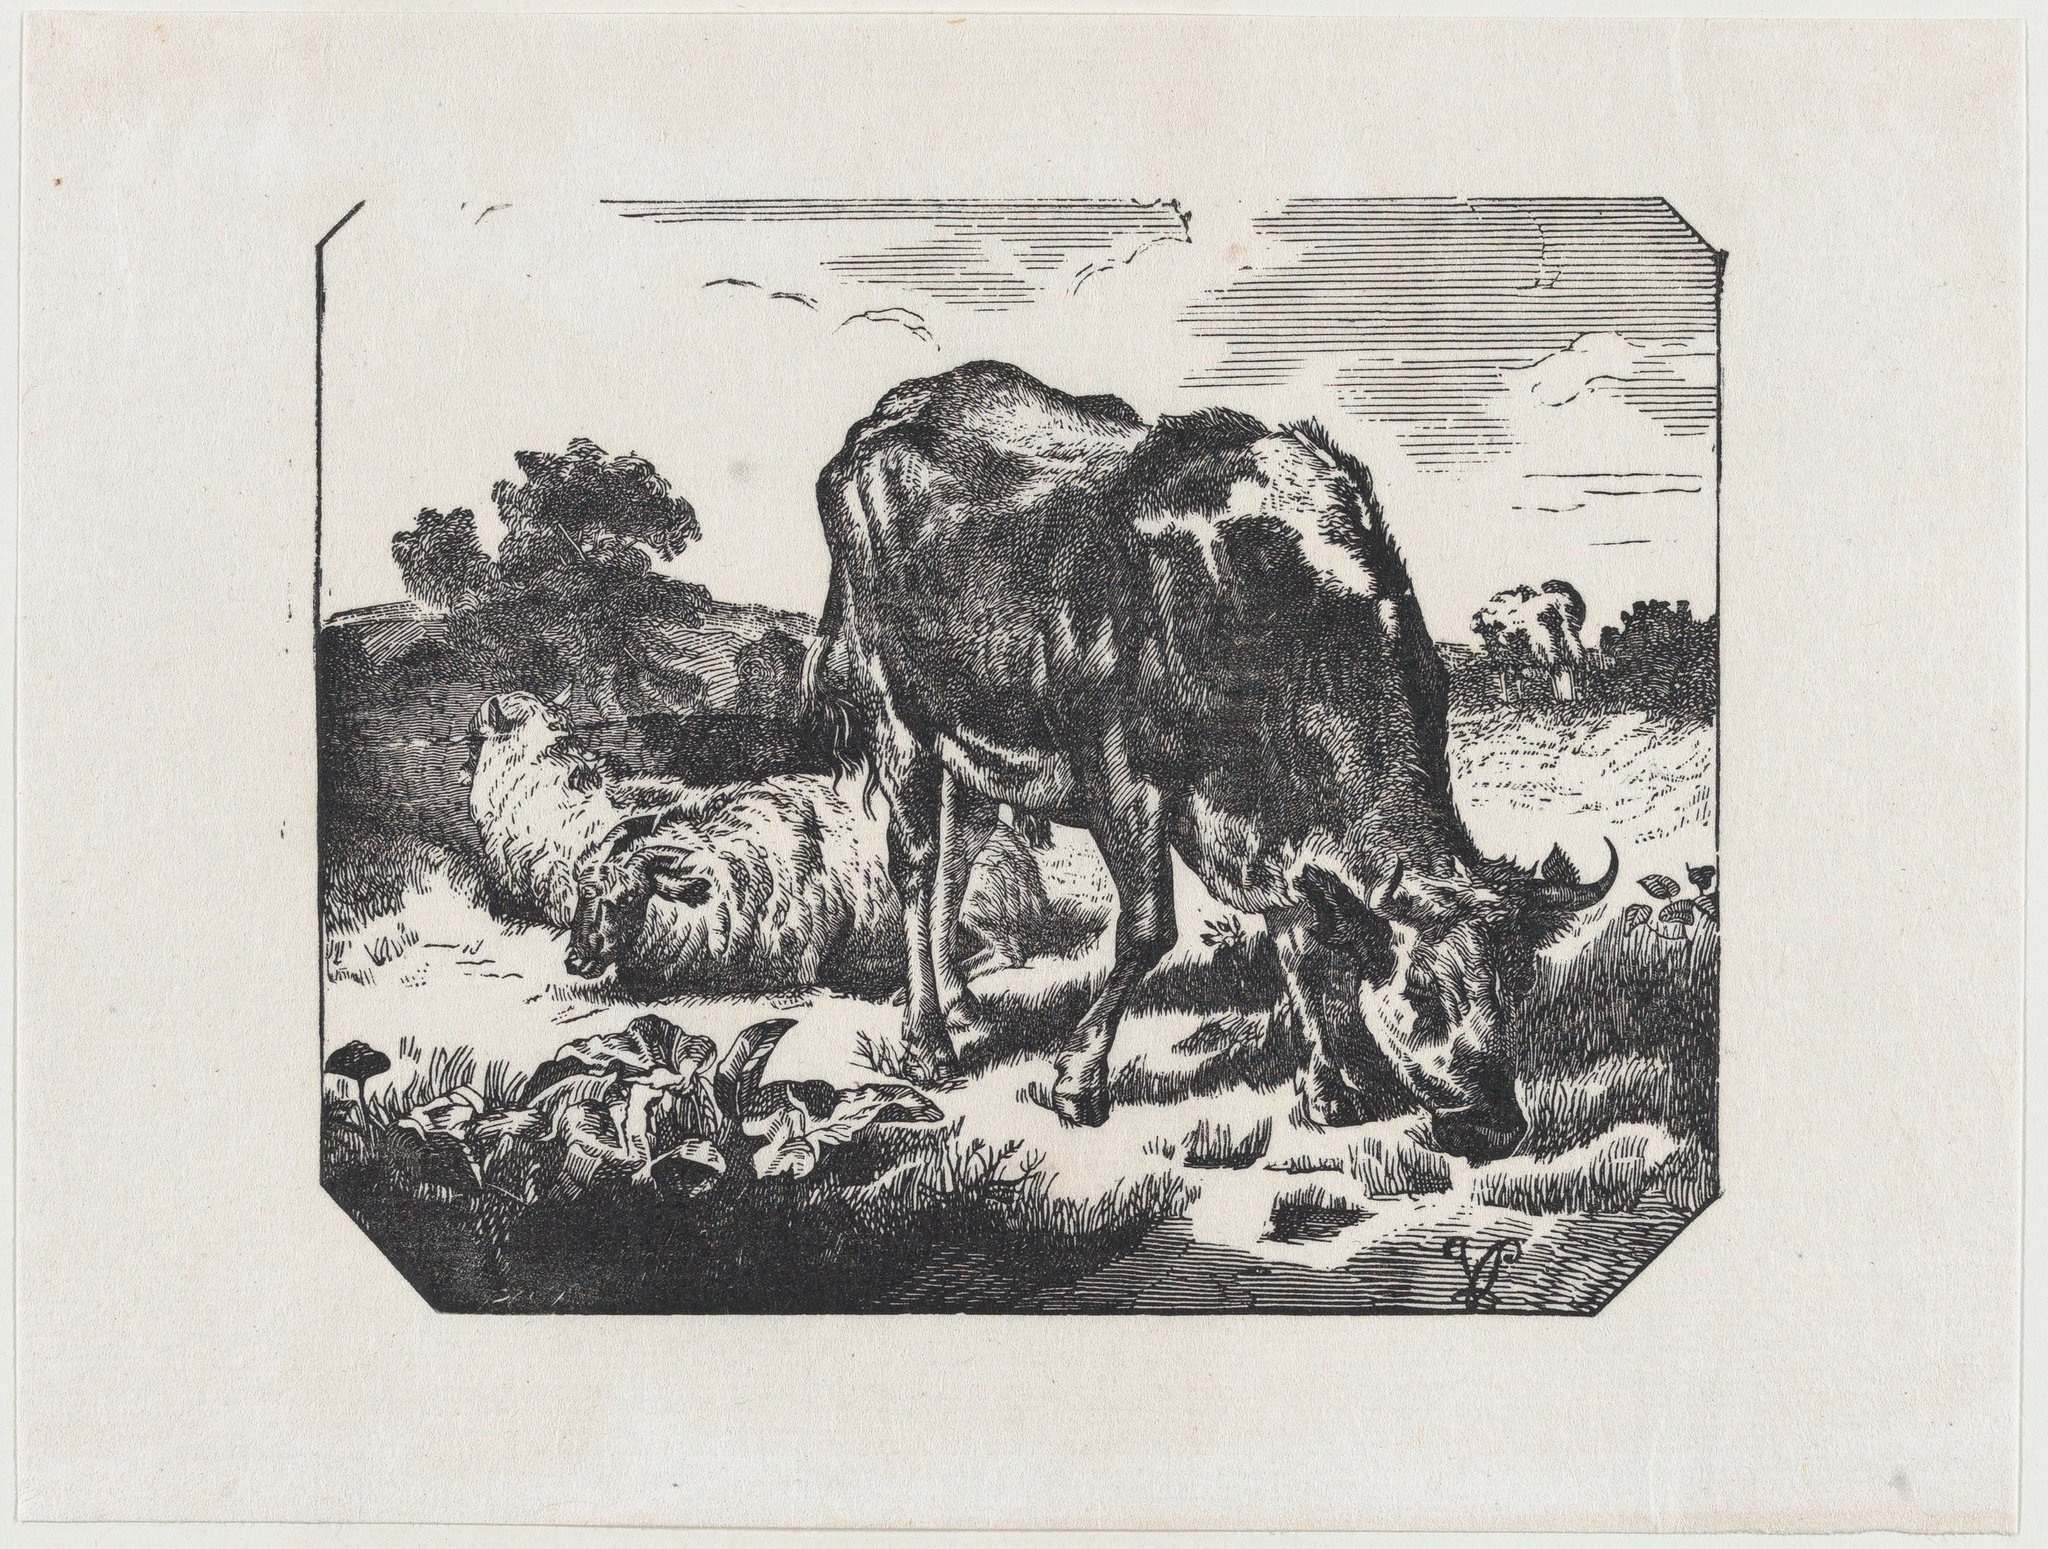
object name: print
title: Bull and sheep in a pasture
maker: anonymous, mexican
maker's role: artist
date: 1801-1900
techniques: engraving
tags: bulls,sheep